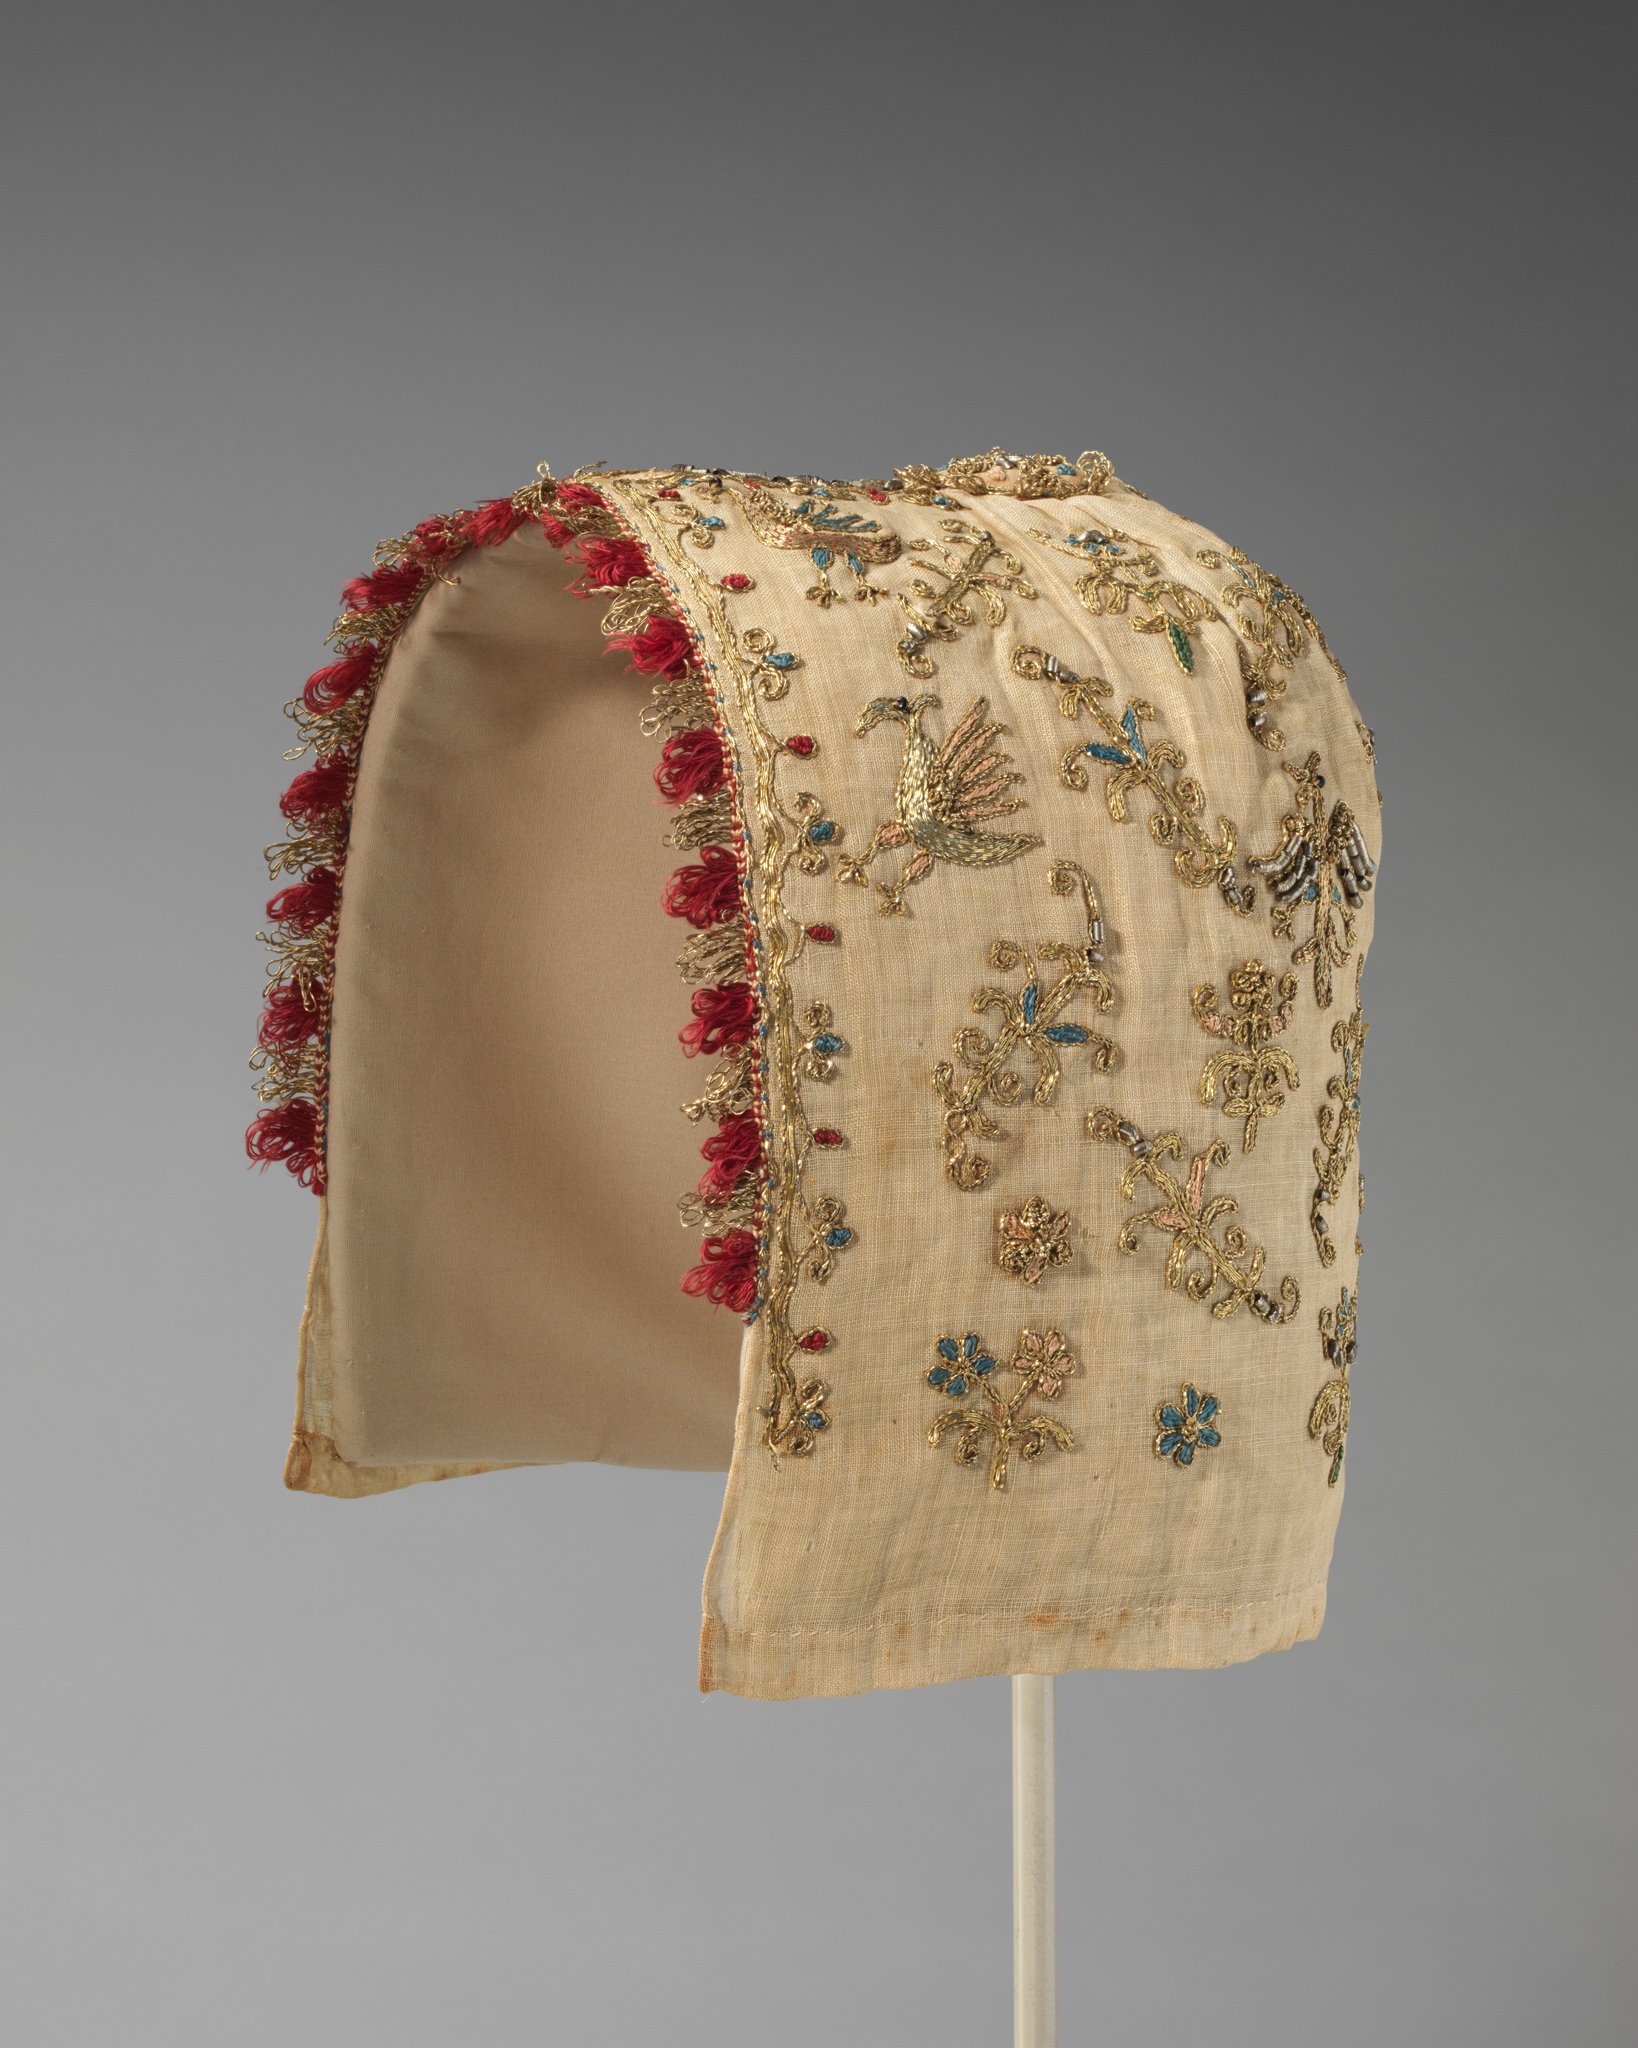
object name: cap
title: Woman's cap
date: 1500-1525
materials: glass, linen, metal thread, silk